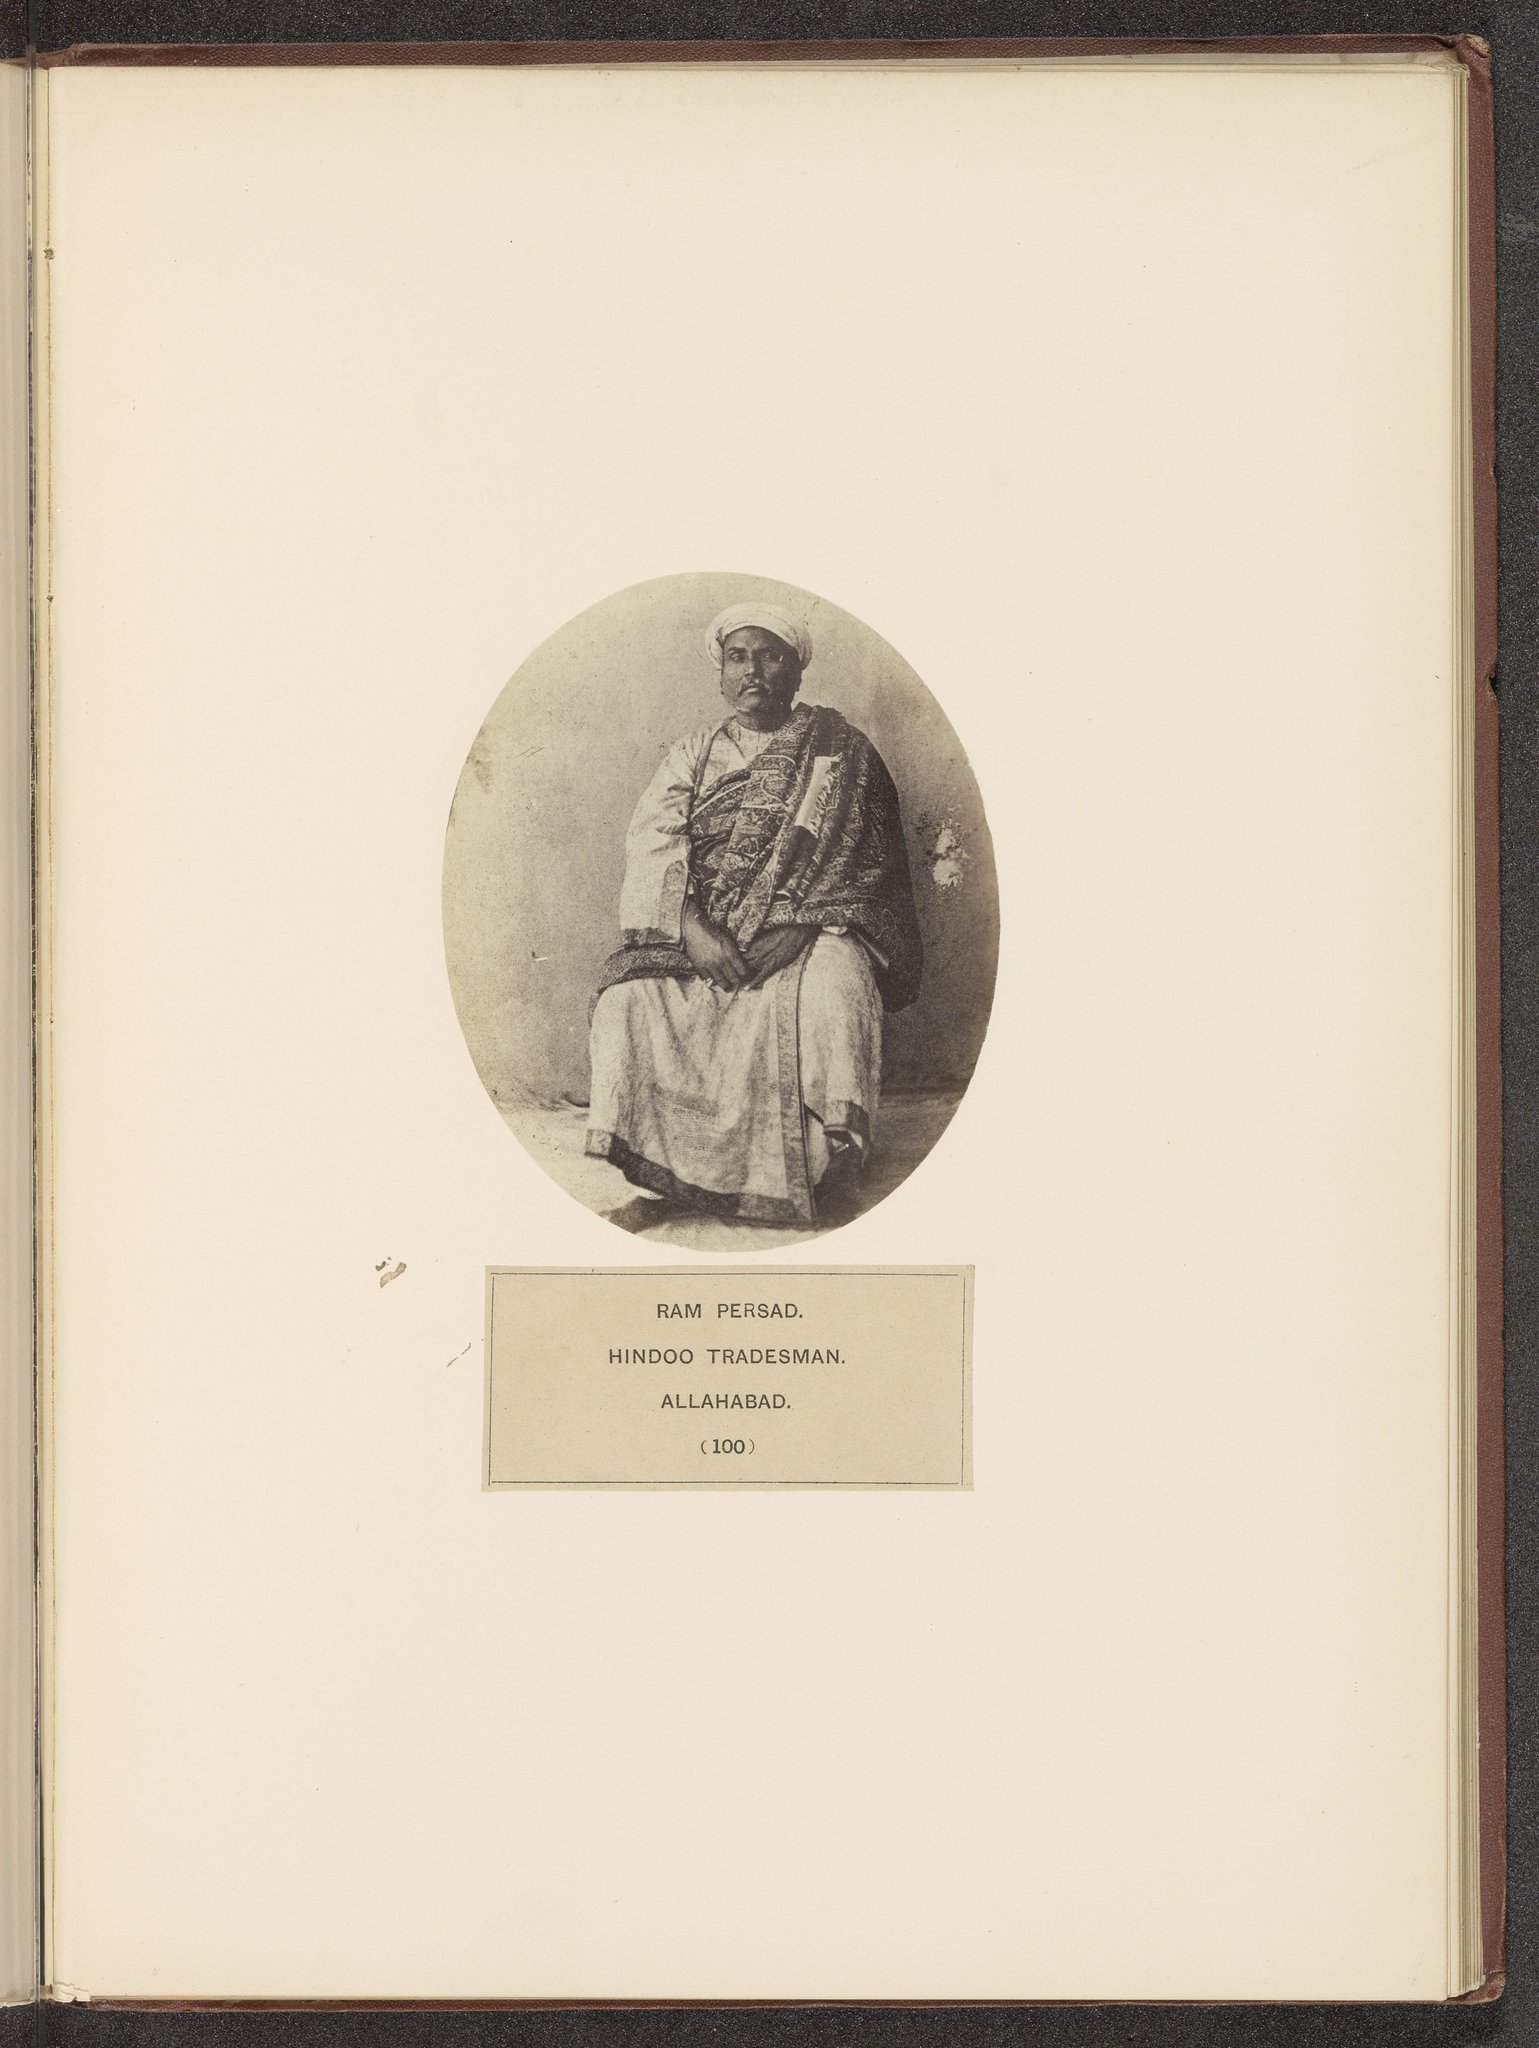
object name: photograph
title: Portrait of a tradesman Ram Persad from Prayagraj, Uttar Pradesh, India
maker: Anonymous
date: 1858-1868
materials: photographic support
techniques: albumen print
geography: allahabad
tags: head-gear: turban, human races; peoples; nationalities, persons engaged in trade and commerce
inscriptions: inscription: ‘RAM PERSAD./ HINDOO TRADESMAN./ ALLAHABAD.’, number: ‘(100)’